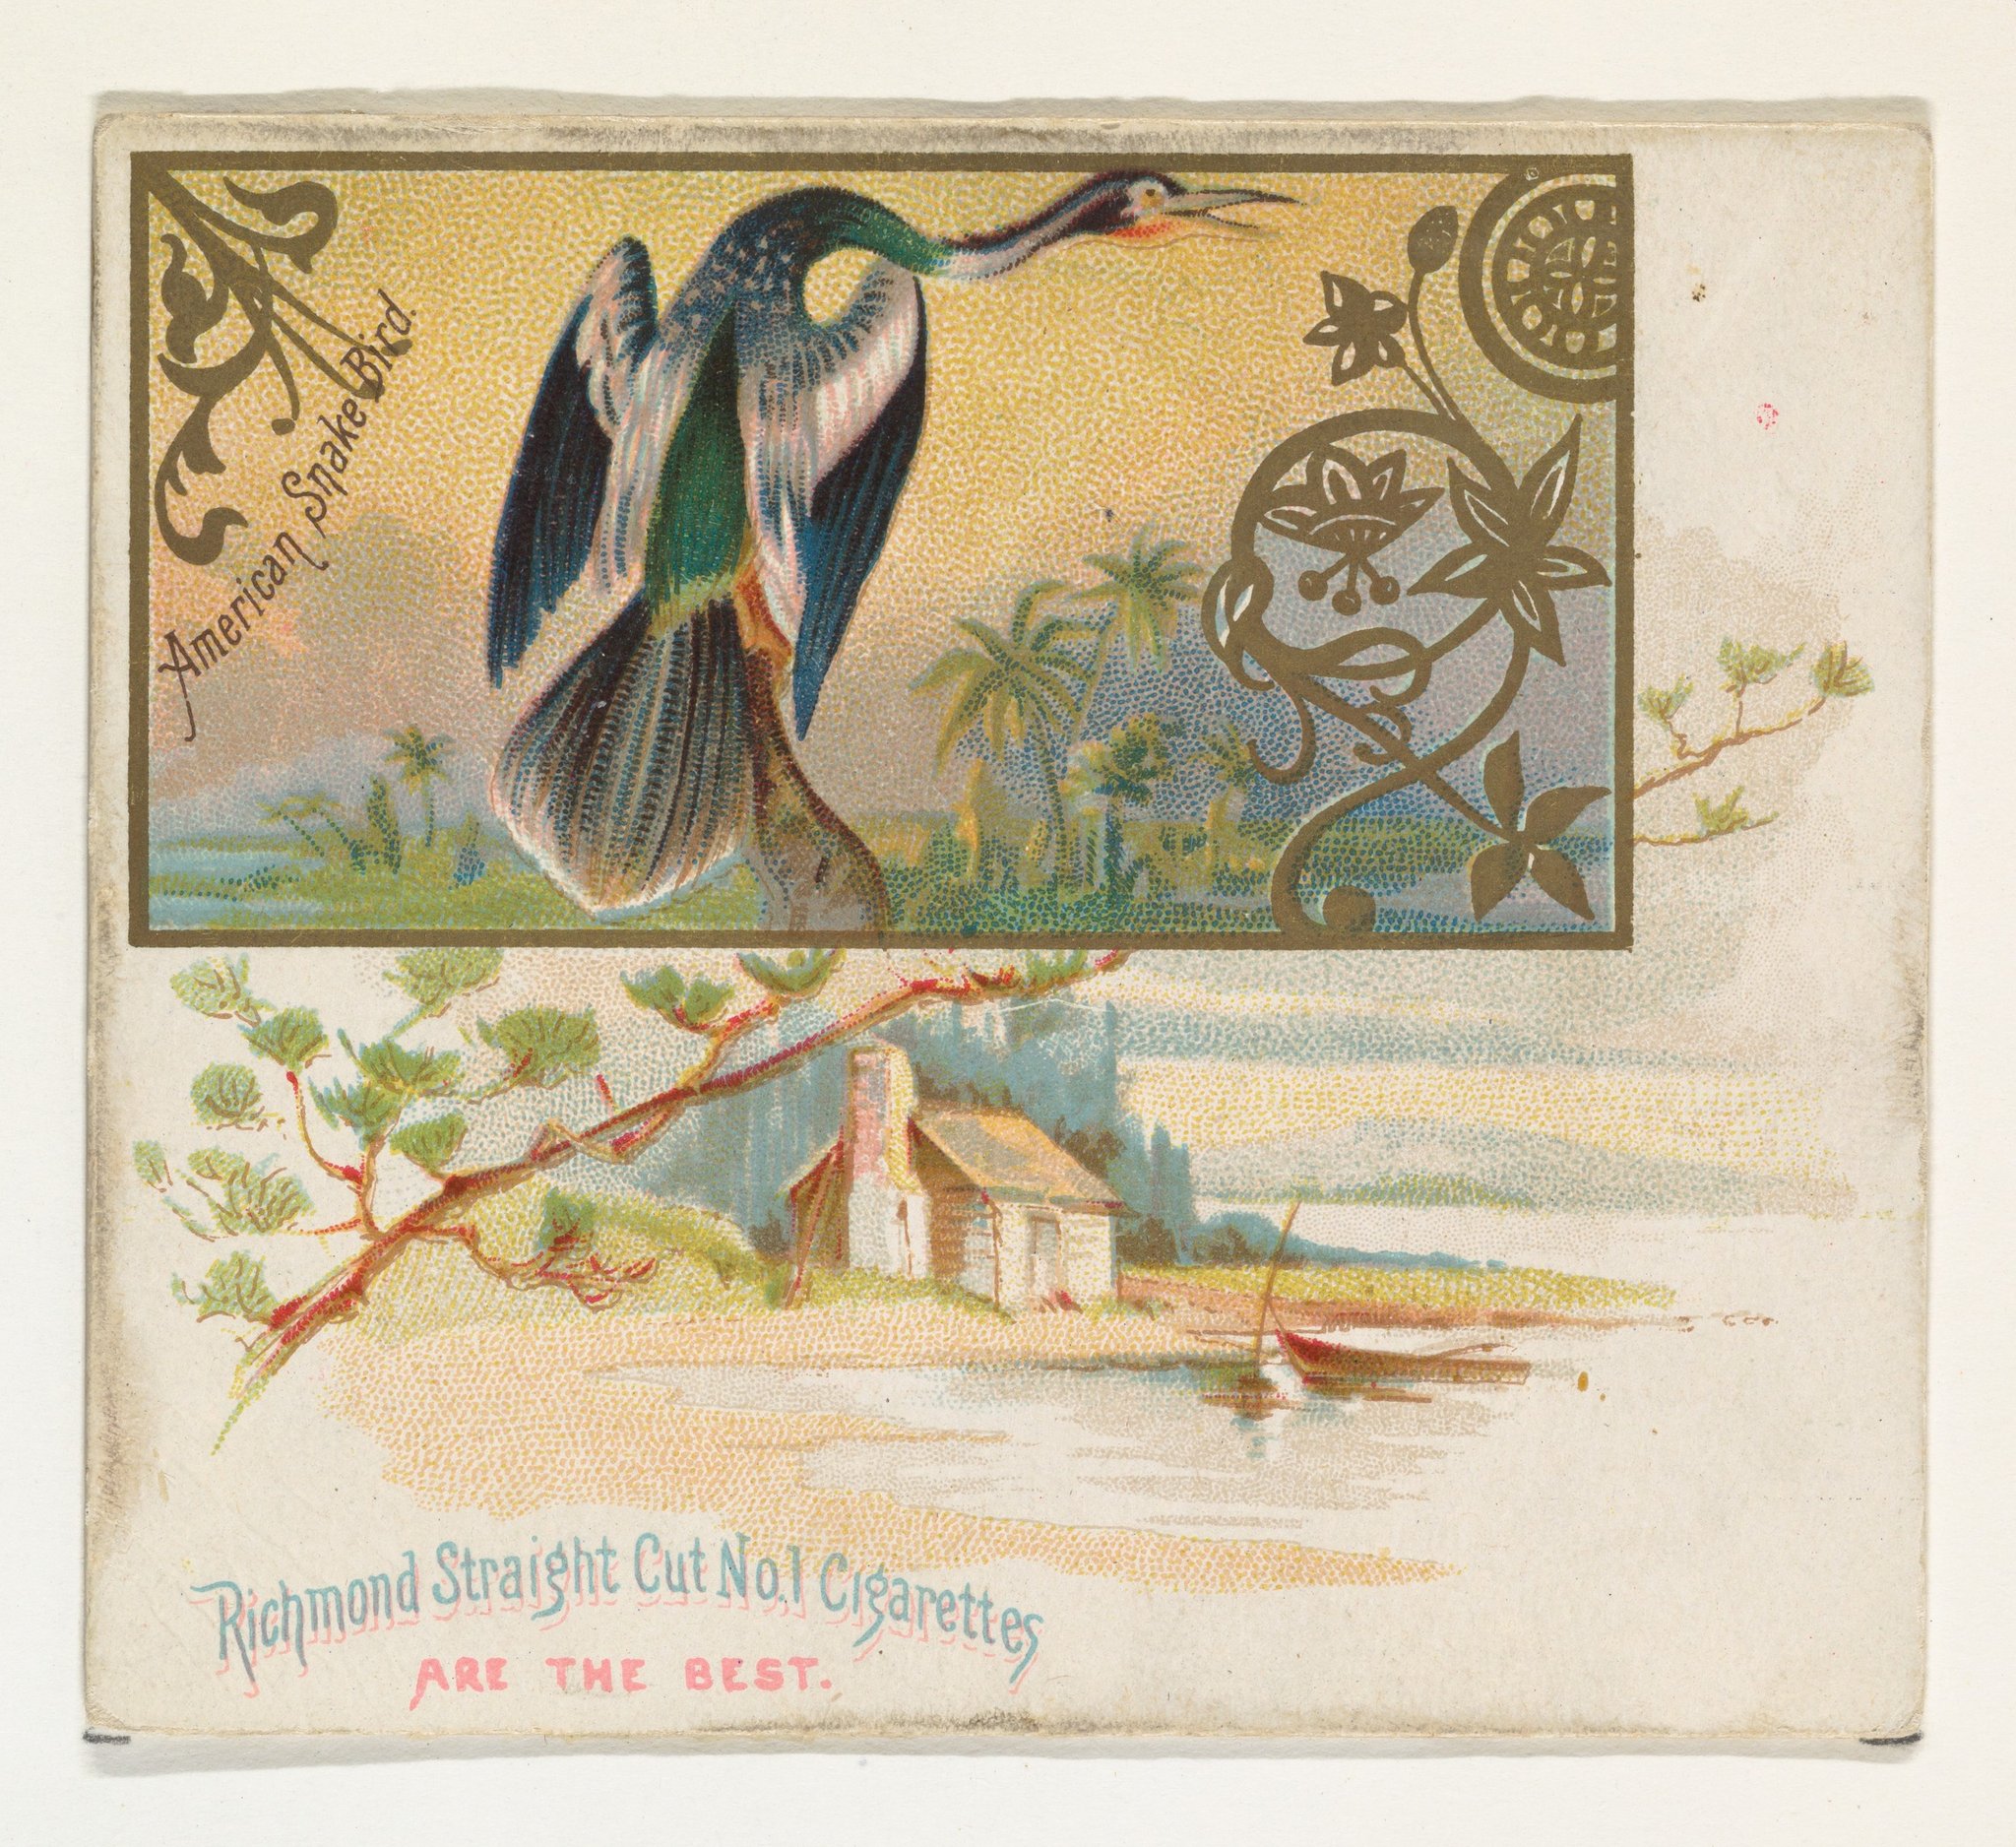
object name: print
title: American Snake Bird, from the Game Birds series (N40) for Allen & Ginter Cigarettes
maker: allen & ginter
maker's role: publisher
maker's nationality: american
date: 1888-1890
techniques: color lithograph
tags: birds